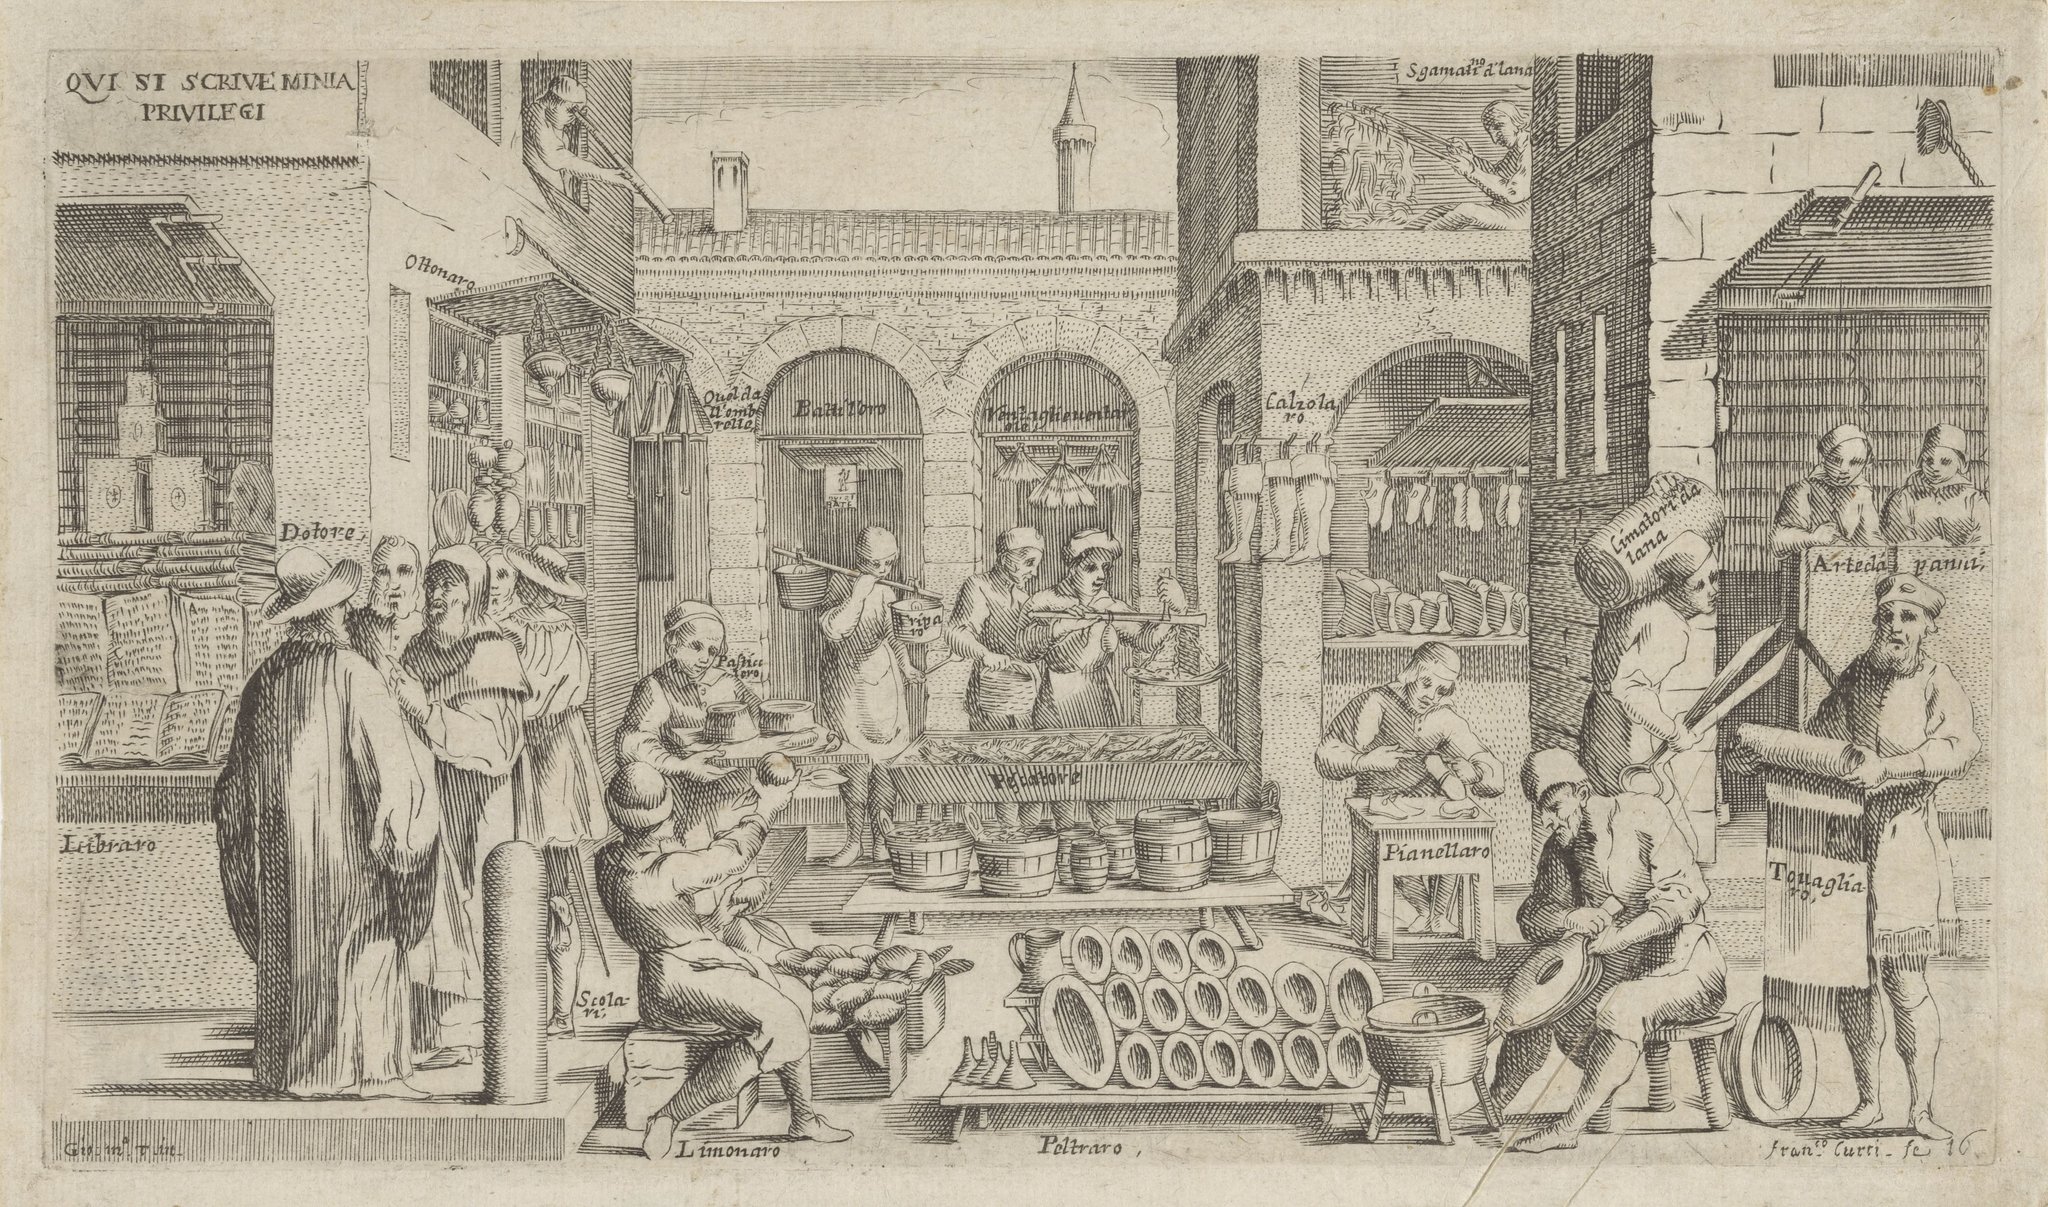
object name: print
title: Ambachtslieden in Bologna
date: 1640-1660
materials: paper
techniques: engraving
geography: italy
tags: shop, store, handicrafts, craftsman at work, stall, booth (~ market), house combined with shop, workshop, shoe-maker, cobbler, book-shop, bookseller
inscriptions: collector's mark: ‘S E’, collector's mark: Lugt 2760, collector's mark: Lugt 2228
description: Ambachtslieden van verschillende beroepen aan het werk in en voor hun winkels in Bologna. Links de etalage van een boekwinkel, waarvoor drie geleerden staan te discussieren. Etalages van een goudsmid, een waaierwinkel en een schoenmaker. Op het plein staat een visstal, een verkoper van citroenen, een uitstalling met borden en schalen en rechts een omroeper. Linksboven de tekst: Qui si scrive minia privilegi. Bij de winkels en beroepen aanduidingen in het Italiaans. Genummerd rechtsonder: 16.